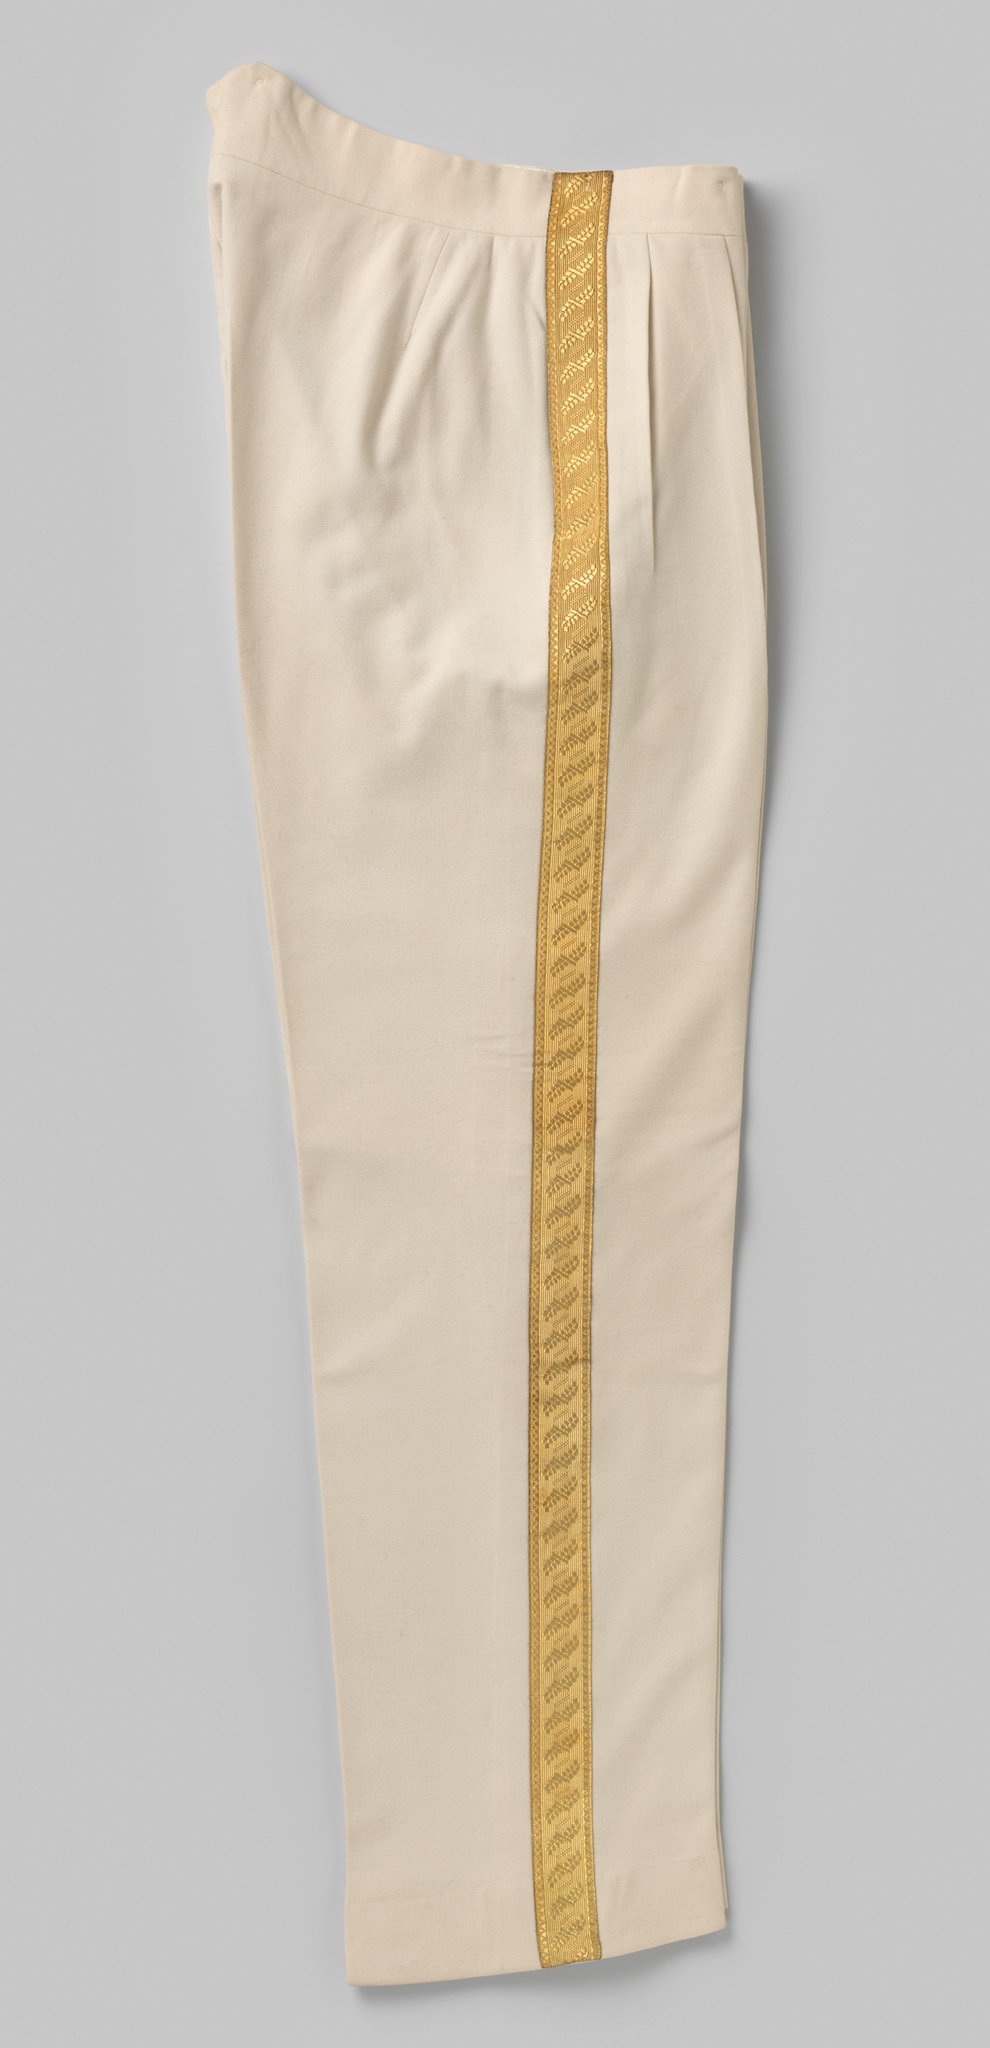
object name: pant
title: Witte broek van ambassadeur Allard Merens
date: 1945-1976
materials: textile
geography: london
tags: the hague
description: Witte broek behorend bij de diplomatieke ambtskleding van ambassadeur Allard Merens.